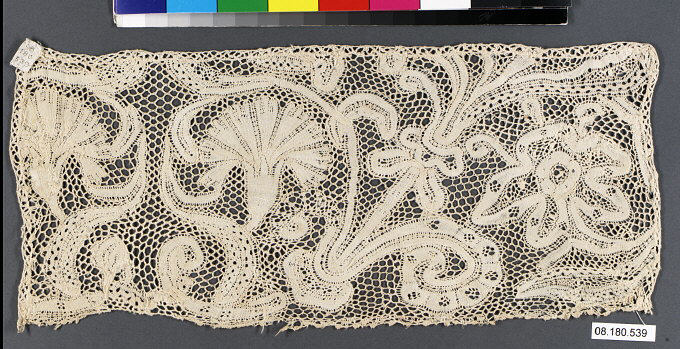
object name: piece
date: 1700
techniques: lace